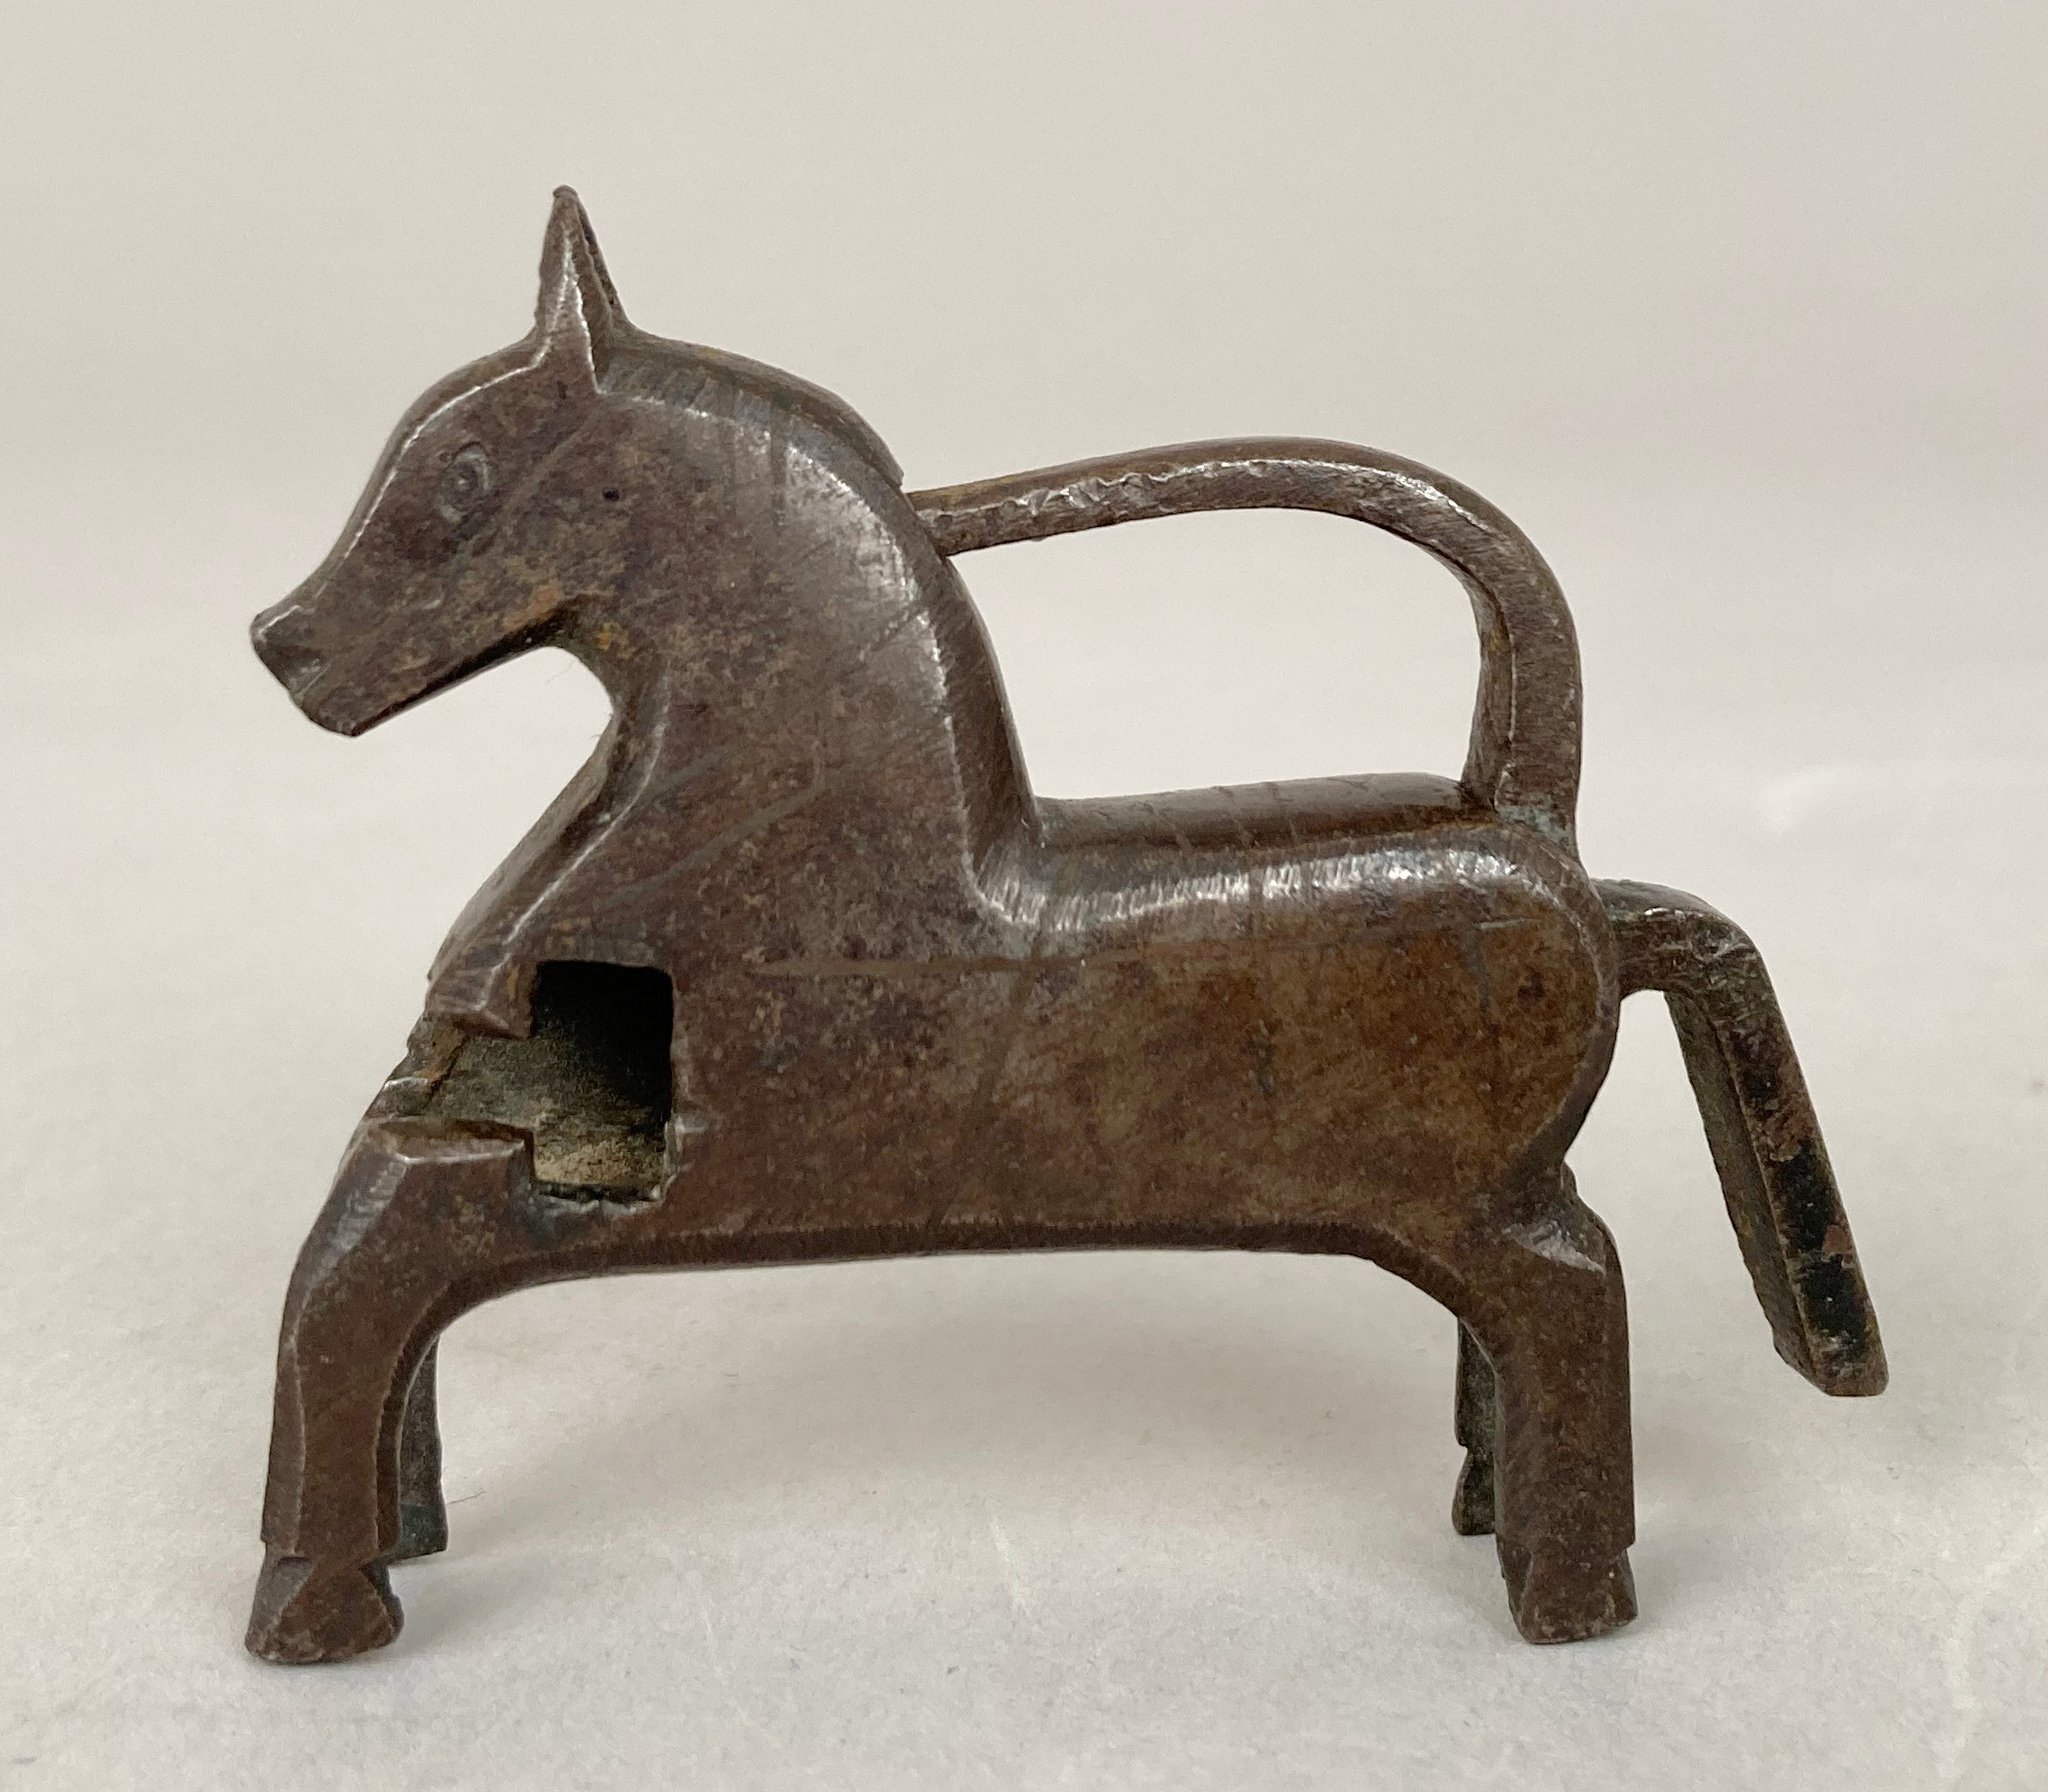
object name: padlock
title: Padlock in the form of a horse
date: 1701-1800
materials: brass, iron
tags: horses